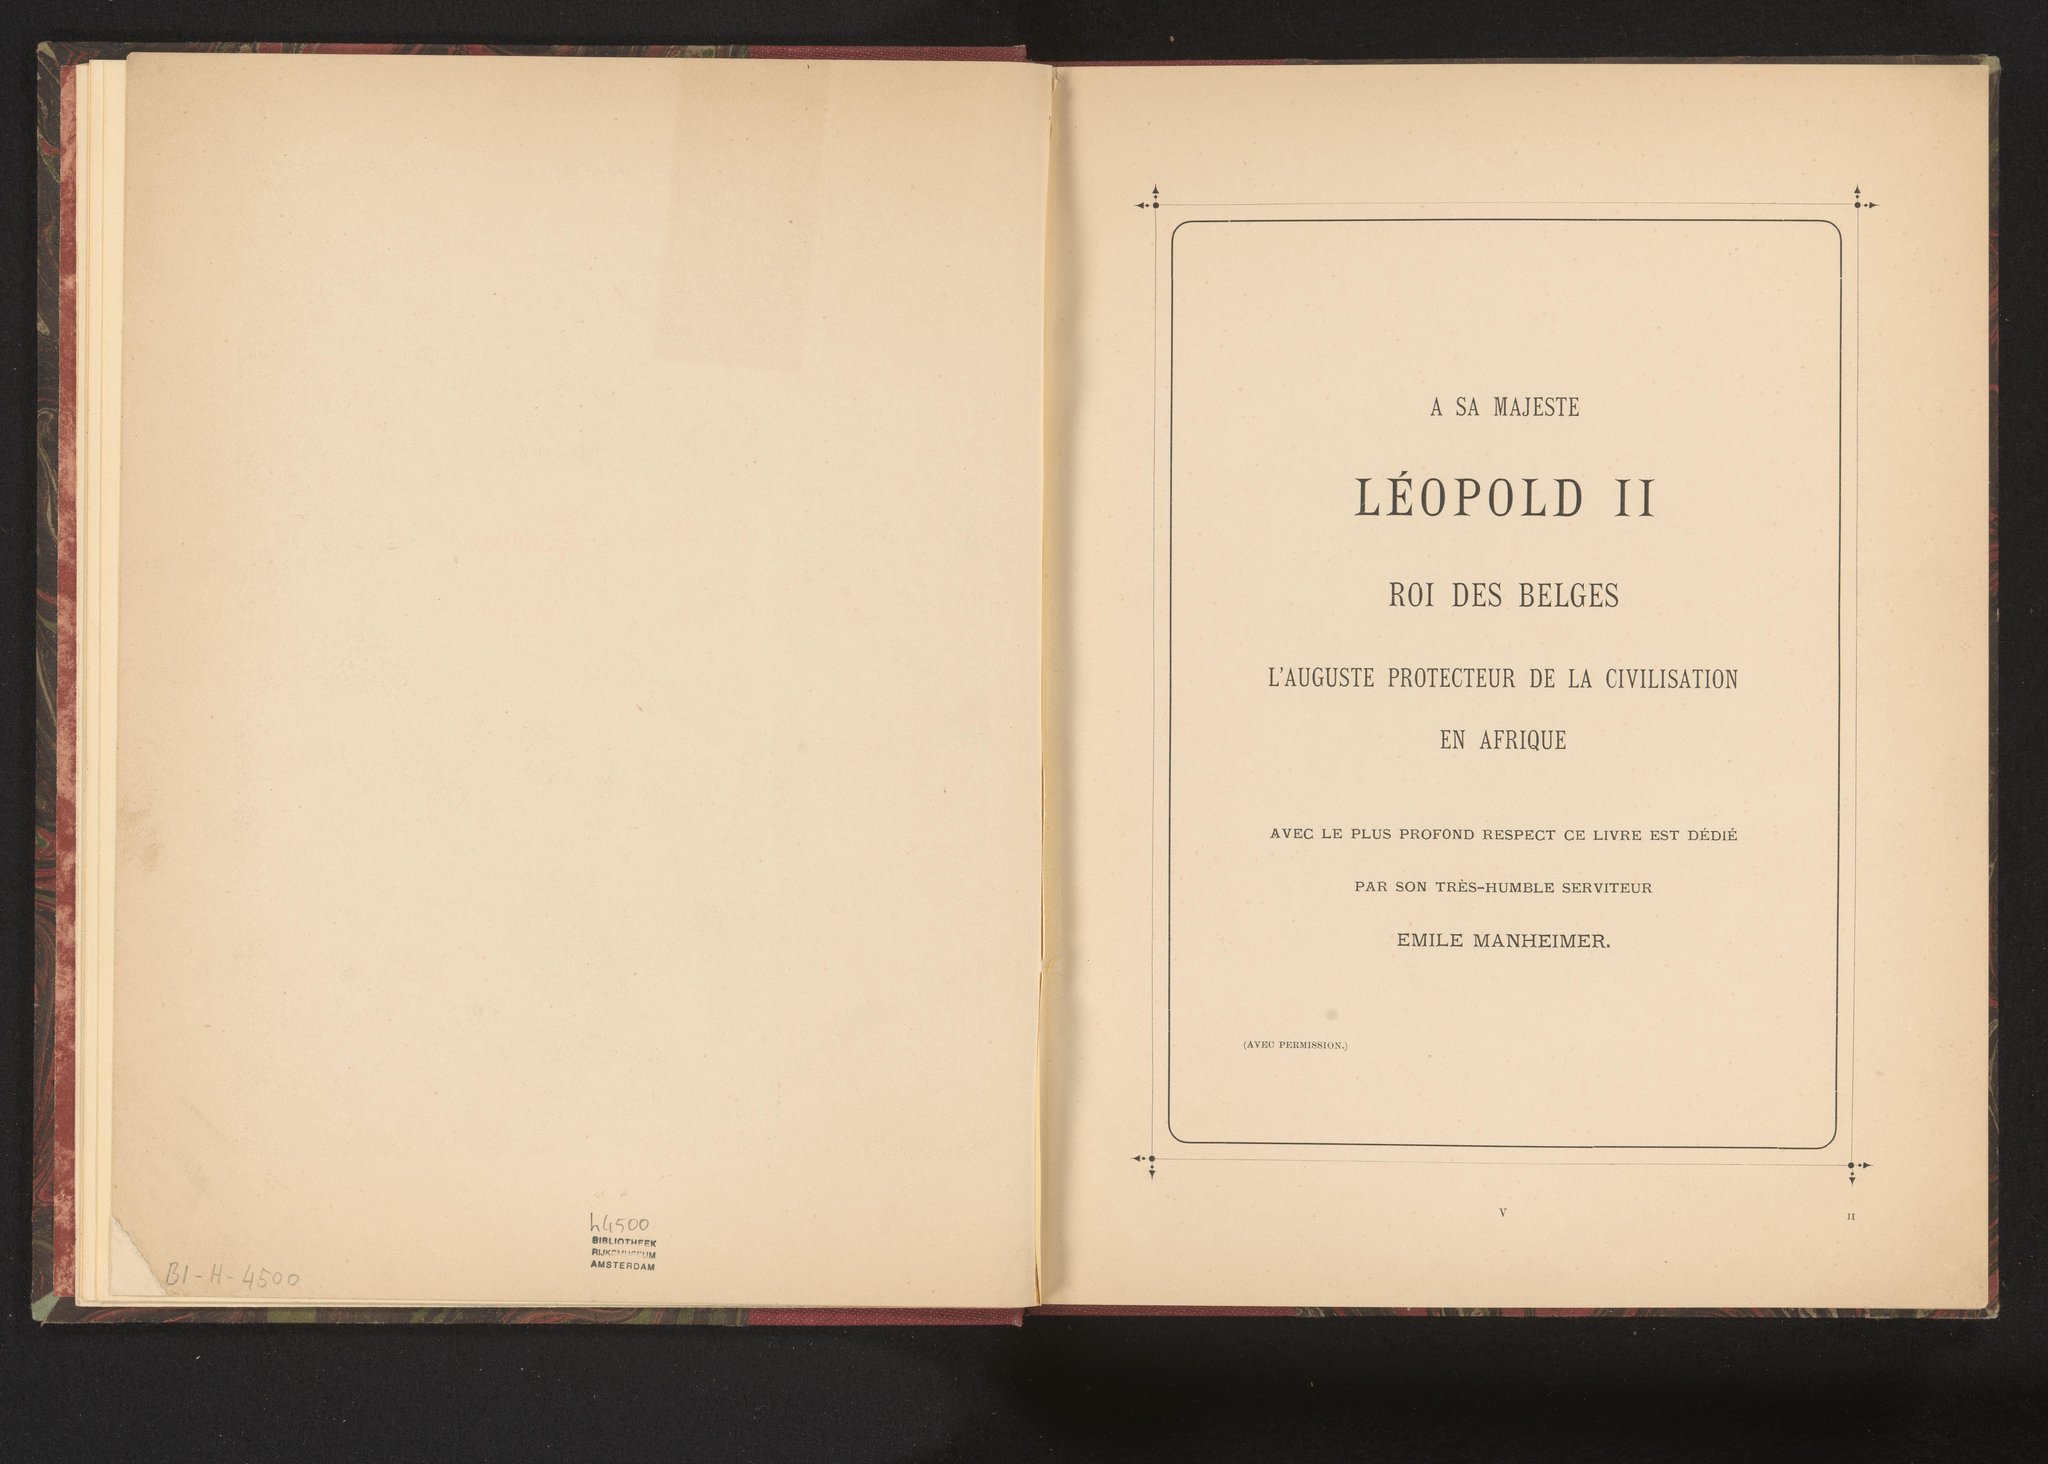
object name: book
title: Du Cap au Zambèze : notes de voyage dans l'Afrique du Sud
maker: émile manheimer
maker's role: schrijver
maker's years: 1843-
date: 1884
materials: cardboard, paper, textile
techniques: albumen print, letterpress printing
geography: baden-baden